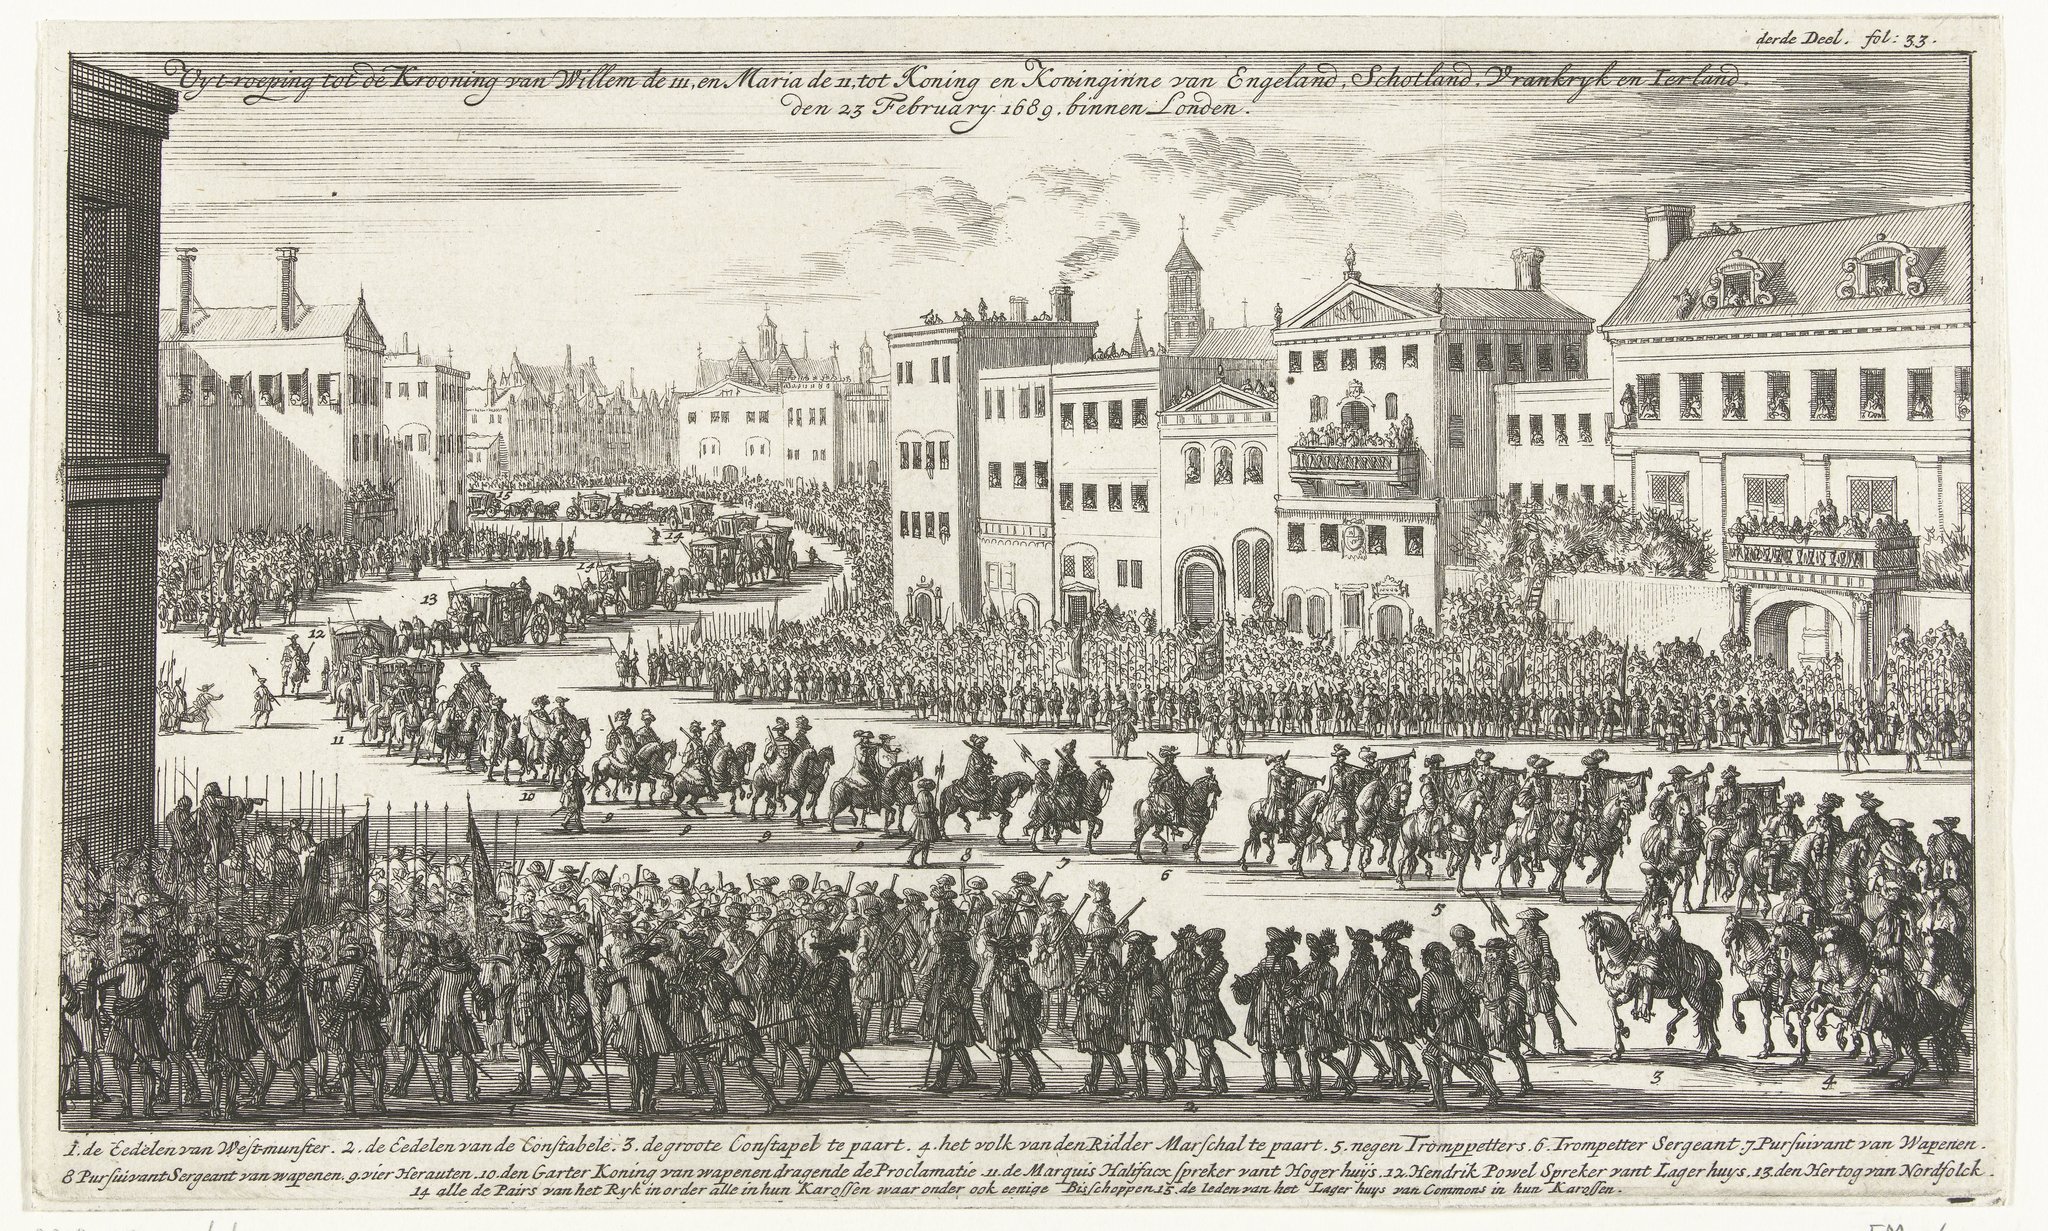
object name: print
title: Uitroep tot kroning van de prins en prinses van Oranje, 1689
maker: jan luyken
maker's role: draughtsman, print maker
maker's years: 1649-1712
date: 1689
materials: paper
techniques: etching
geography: northern netherlands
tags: the hague, william iii (prince of orange and king of england, scotland, and ireland), london, maria ii stuart (koningin van engeland, schotland en ierland), ceremonial procession, parade, pageant ~ installation of a ruler, lower house, parliament, chamber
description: Een lange stoet met de leden van het Parlement door de straten van Londen om een uitroep te doen tot kroning van de prins en prinses van Oranje tot koning en koningin van Engeland, 23 februari 1689. In het onderschrift de legenda 1-15. Gemerkt rechtsboven: derde Deel. fol. 33.